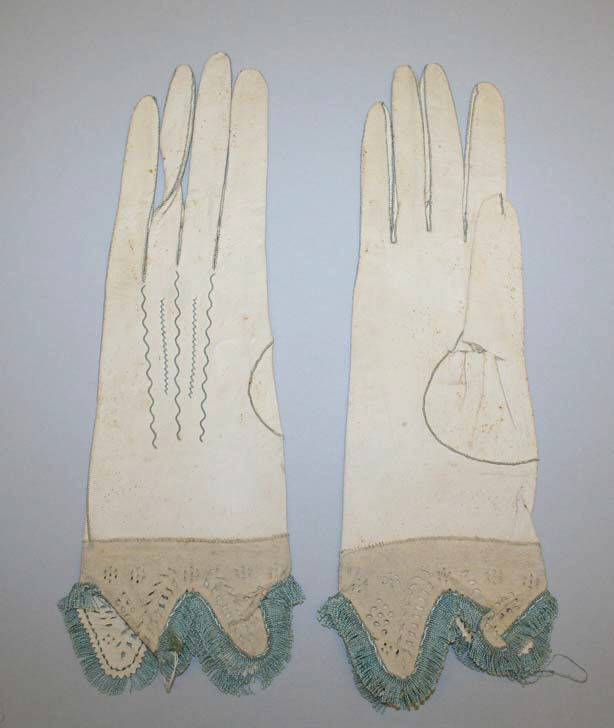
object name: glove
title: Gloves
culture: american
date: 1876-1900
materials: leather, silk